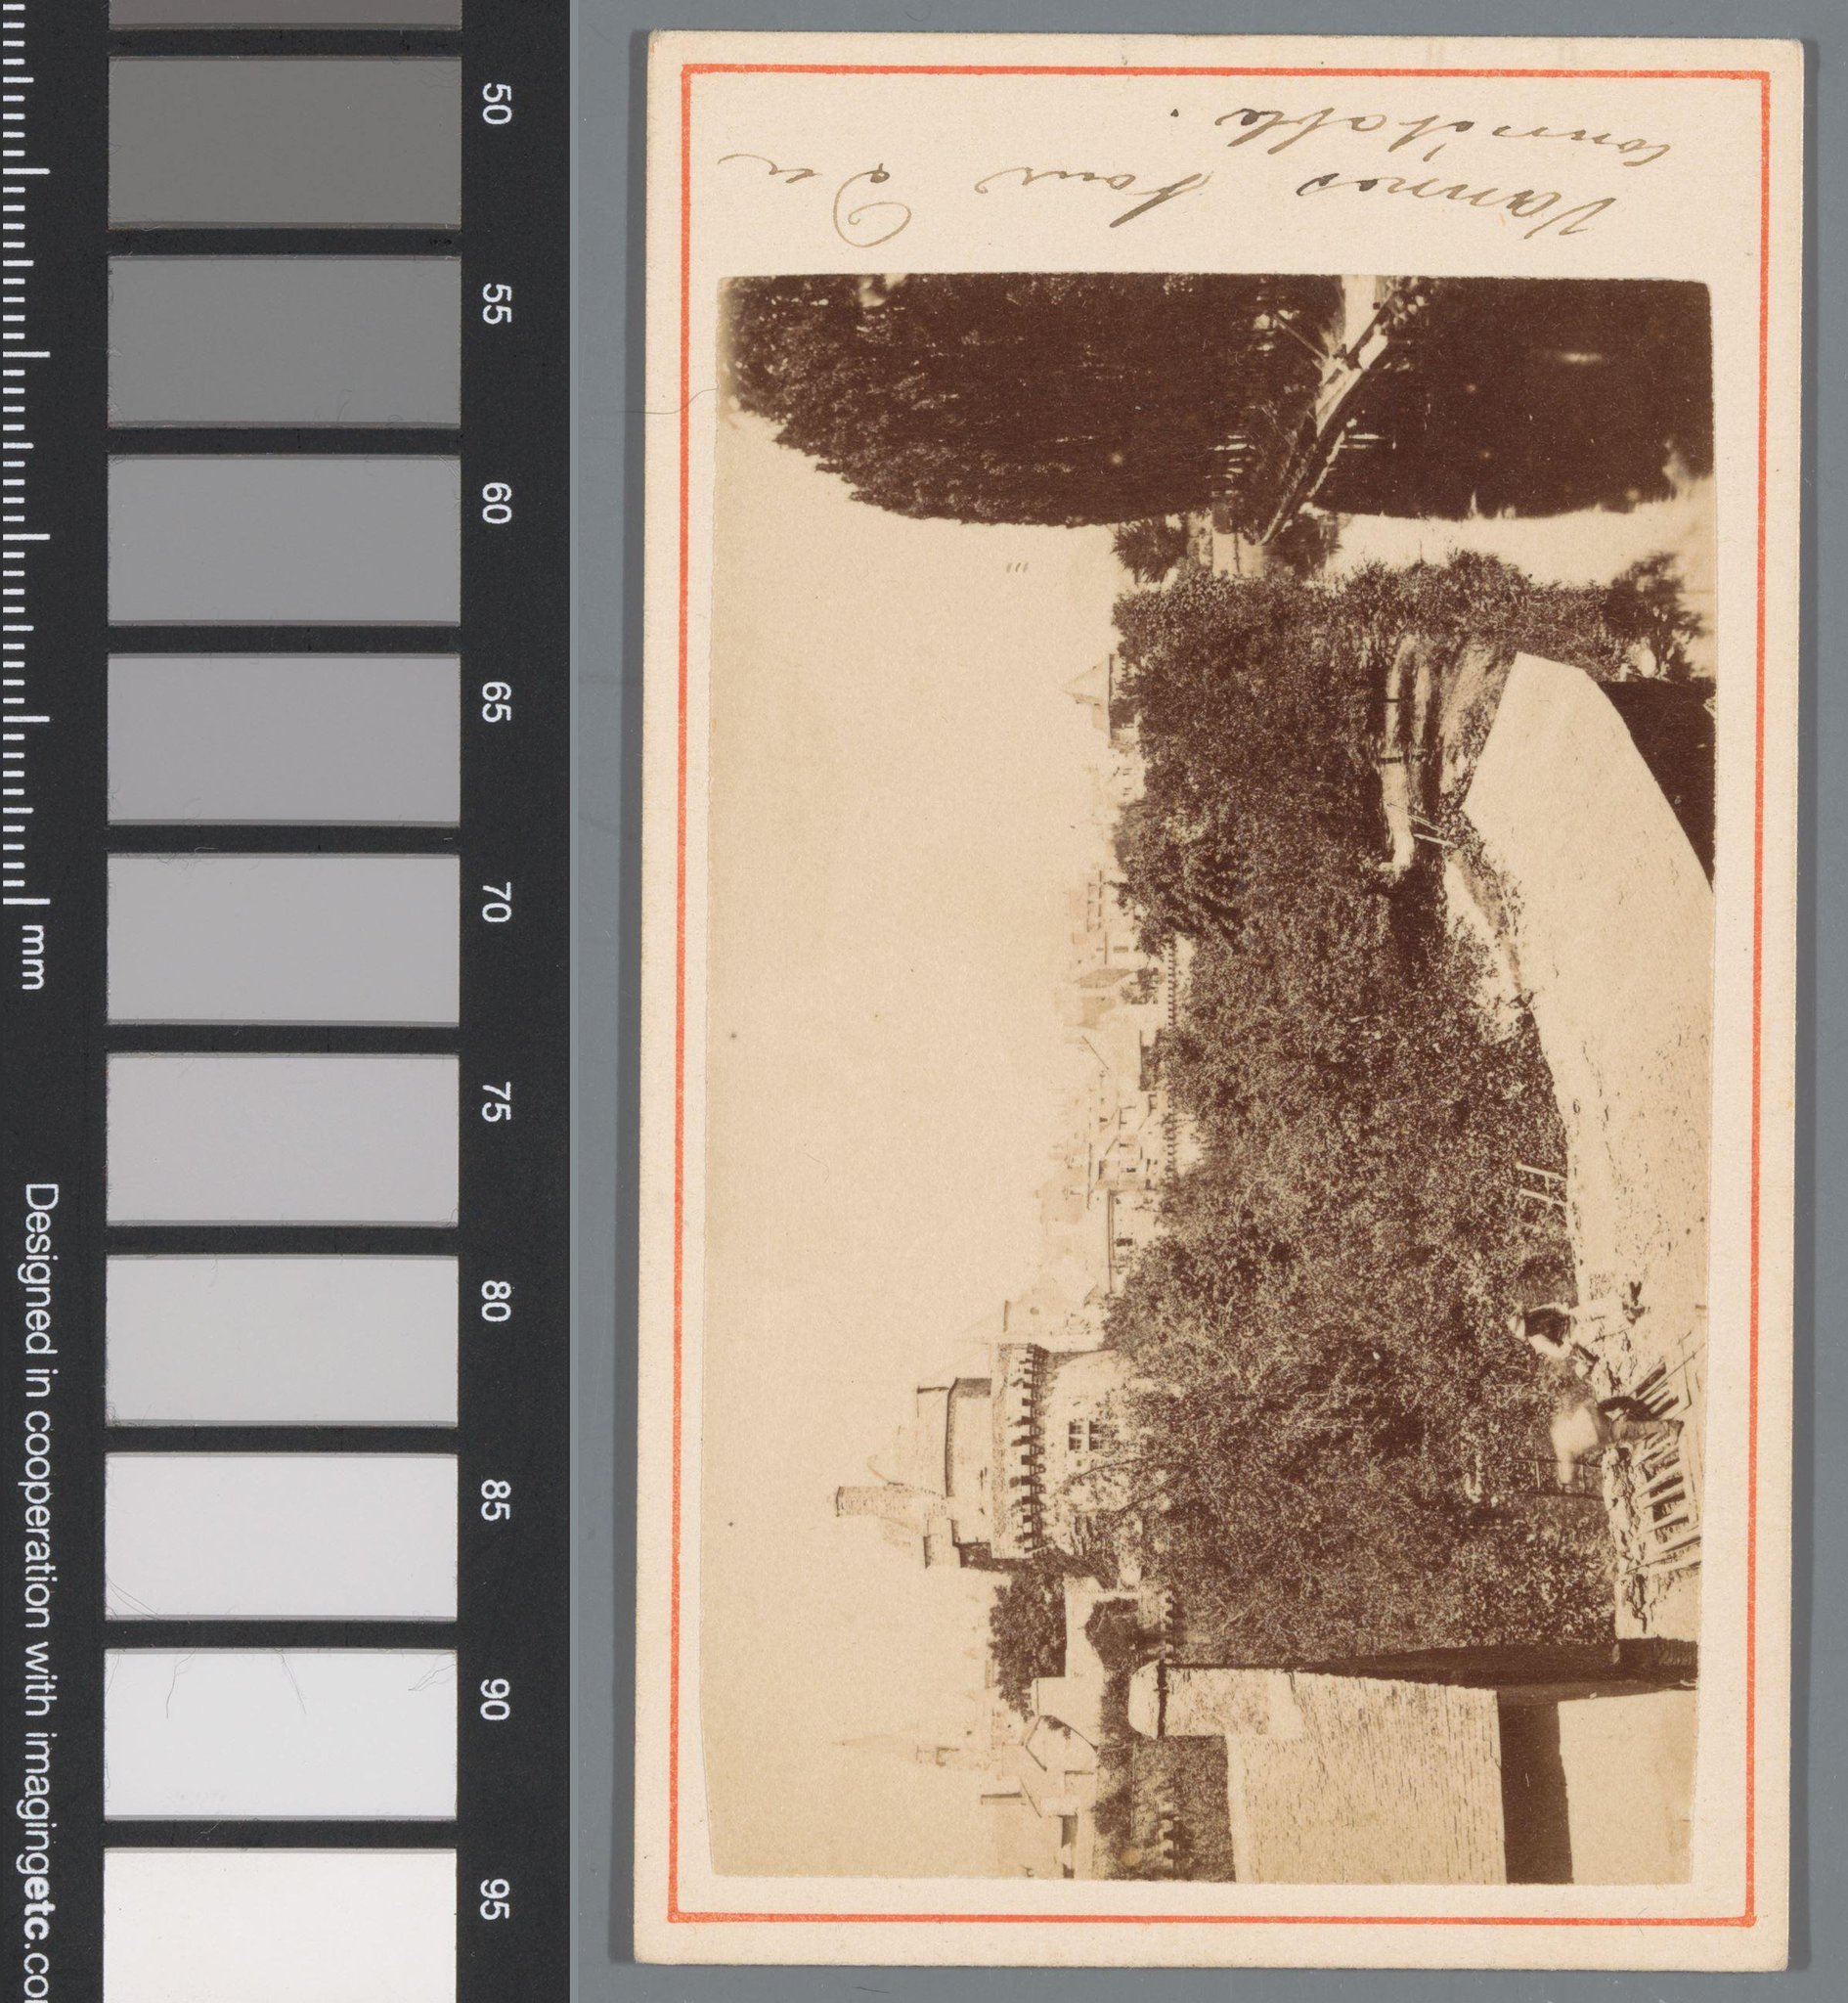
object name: carte de visite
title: Gezicht op de Tour du Connétable, Vannes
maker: ferdinand carlier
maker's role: fotograaf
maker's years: 1829-1892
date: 1855-1869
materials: cardboard, paper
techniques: albumen print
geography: vannes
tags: city-view in general; 'veduta', towers ~ fortified city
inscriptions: inscription: ‘Vannes - tour de/ connetable’, inscription: ‘F. Carlier’